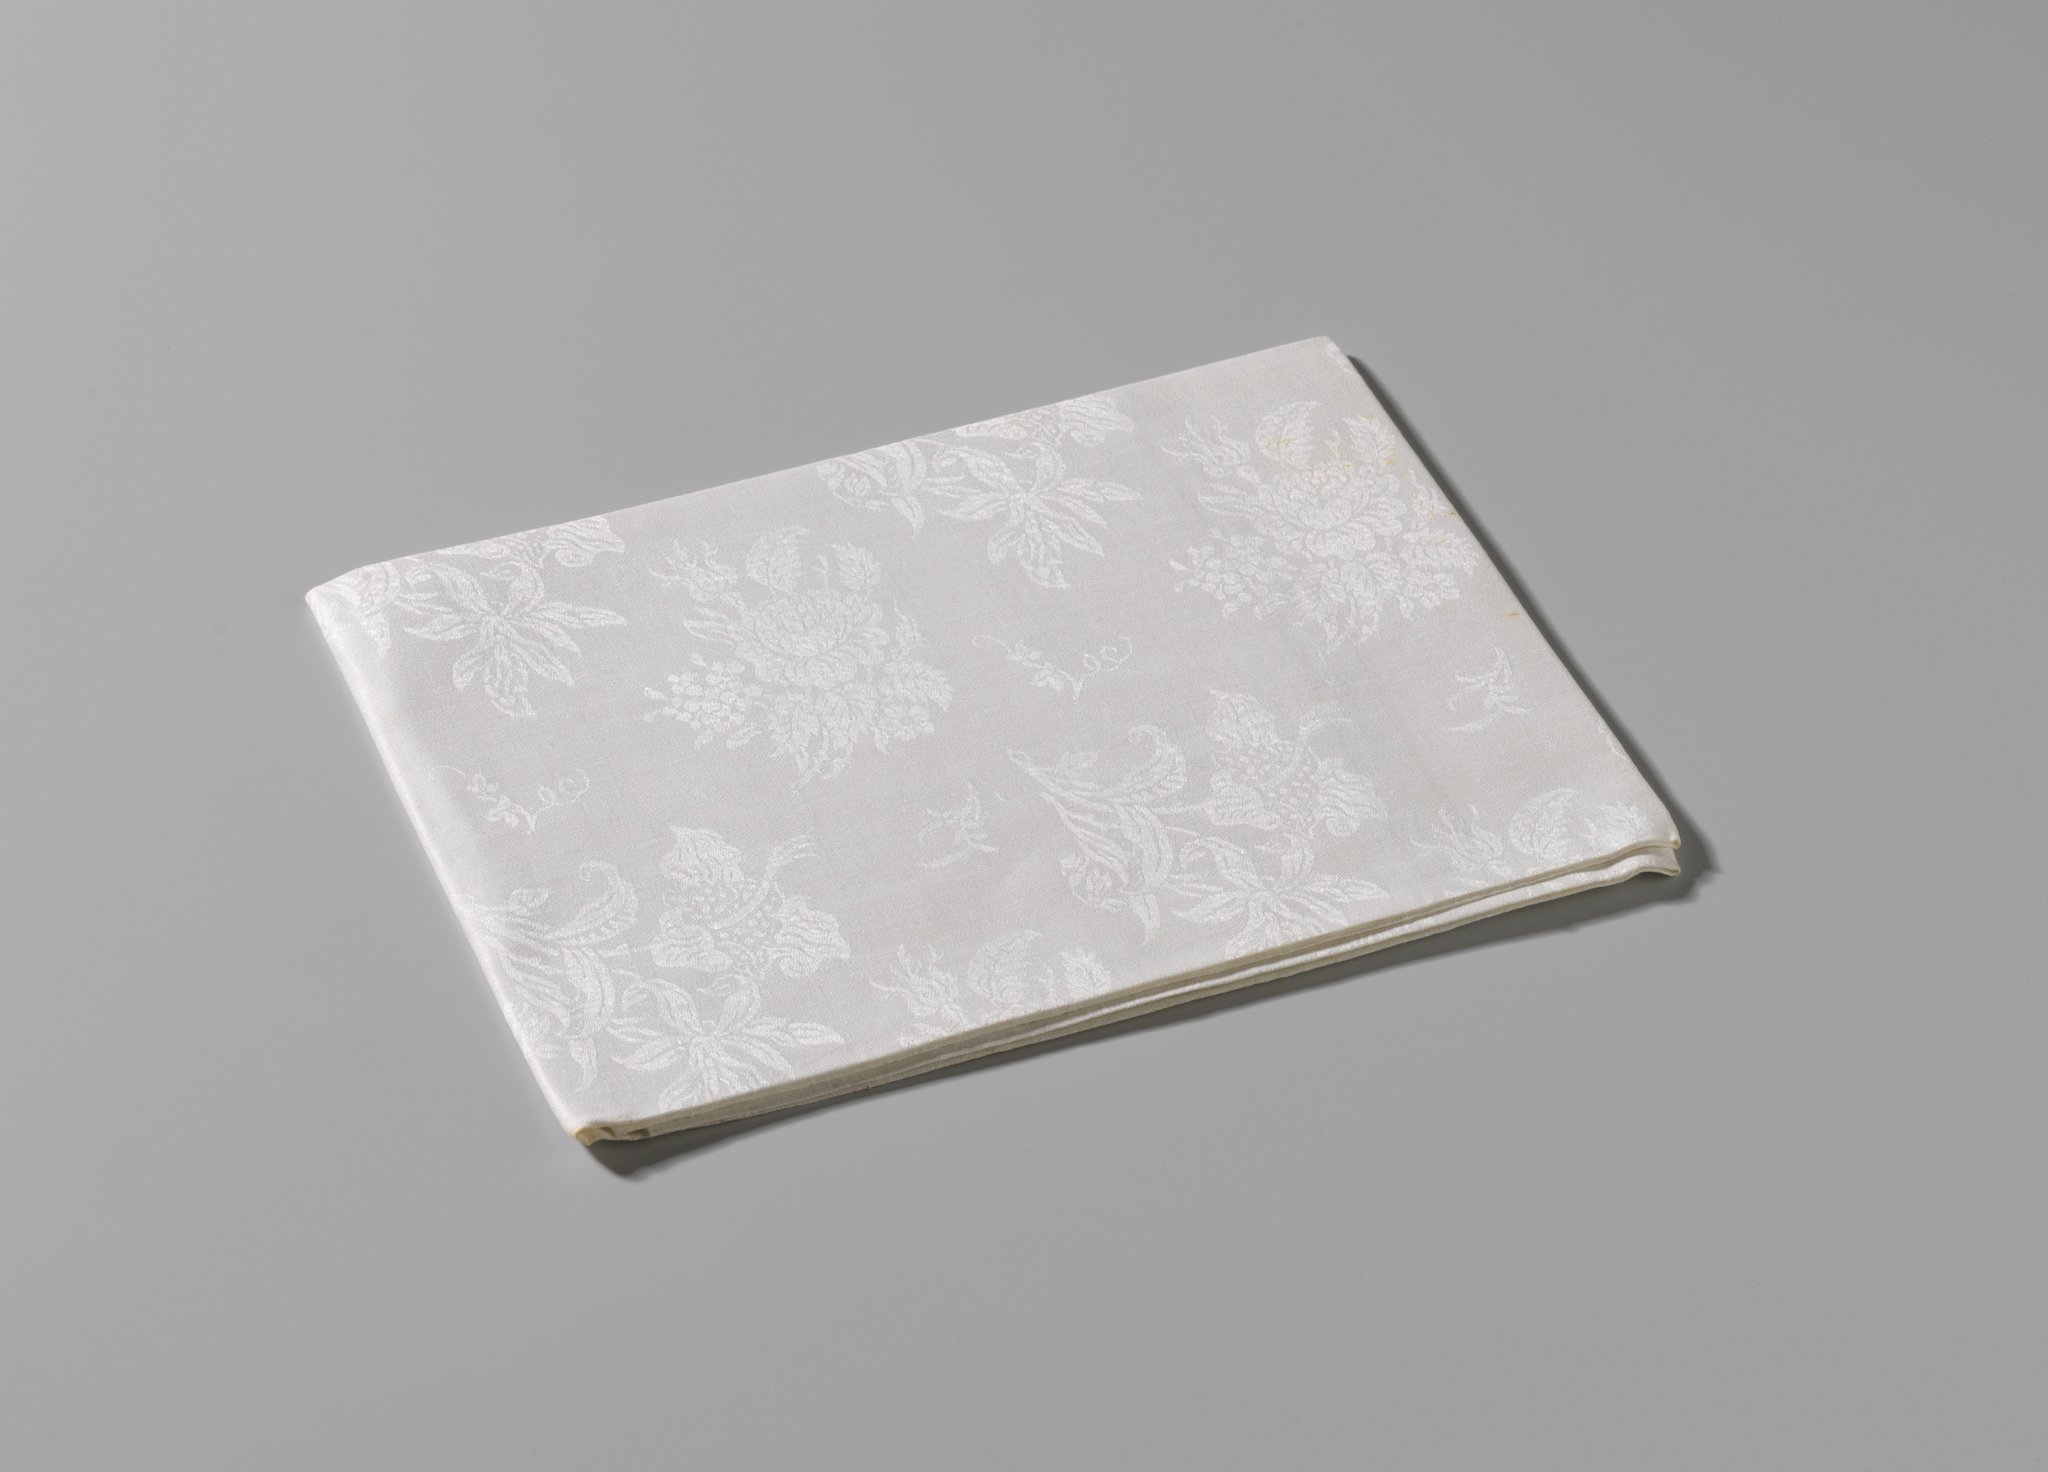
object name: napkin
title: Servet met bloemboeketten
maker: Anonymous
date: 1700-1899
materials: linen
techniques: damask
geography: saxony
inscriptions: mark: ‘GvO’, mark: ‘24’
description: Servet van linnendamast met bloemboeketten. Middenveld: Bloempatroon van verspringende rijen met twee soorten bloemboeketten. Staande en liggende randen: een bloemslinger, de hoeken een bloemboeket.